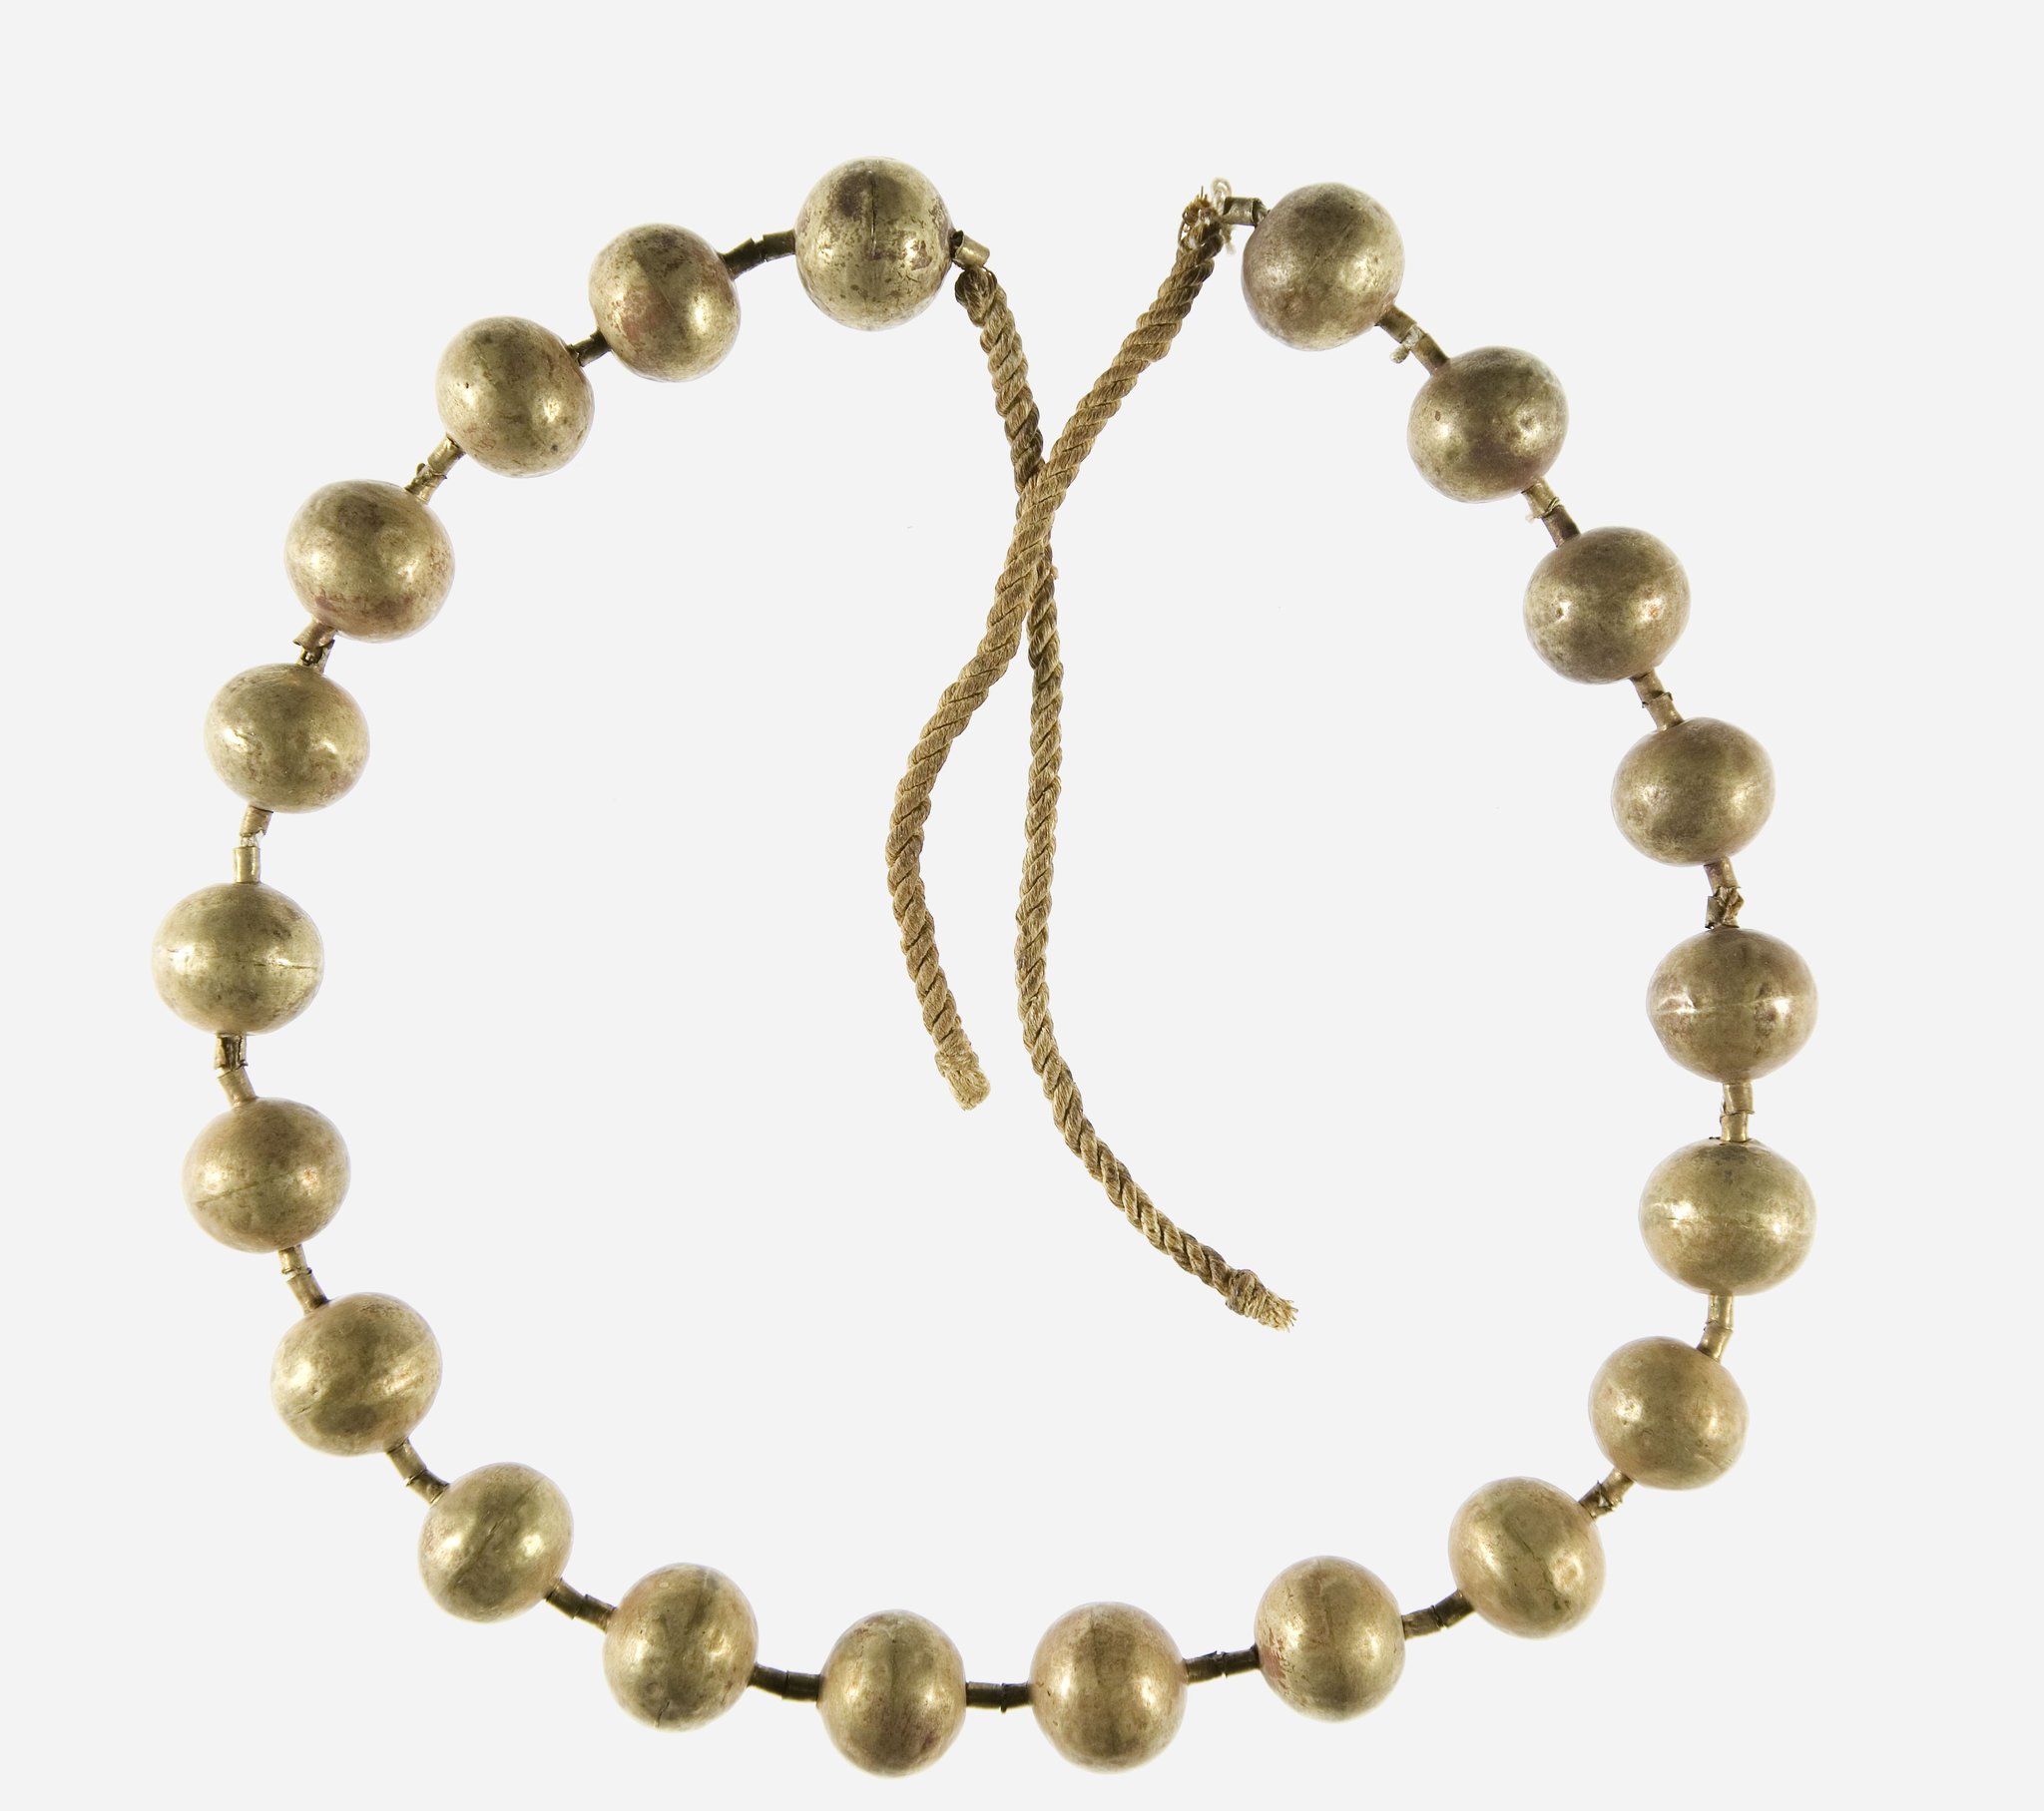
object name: necklace, myt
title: Gold Necklace of the Child Myt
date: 2051-2030 BCE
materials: cord, gold, linen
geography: egypt